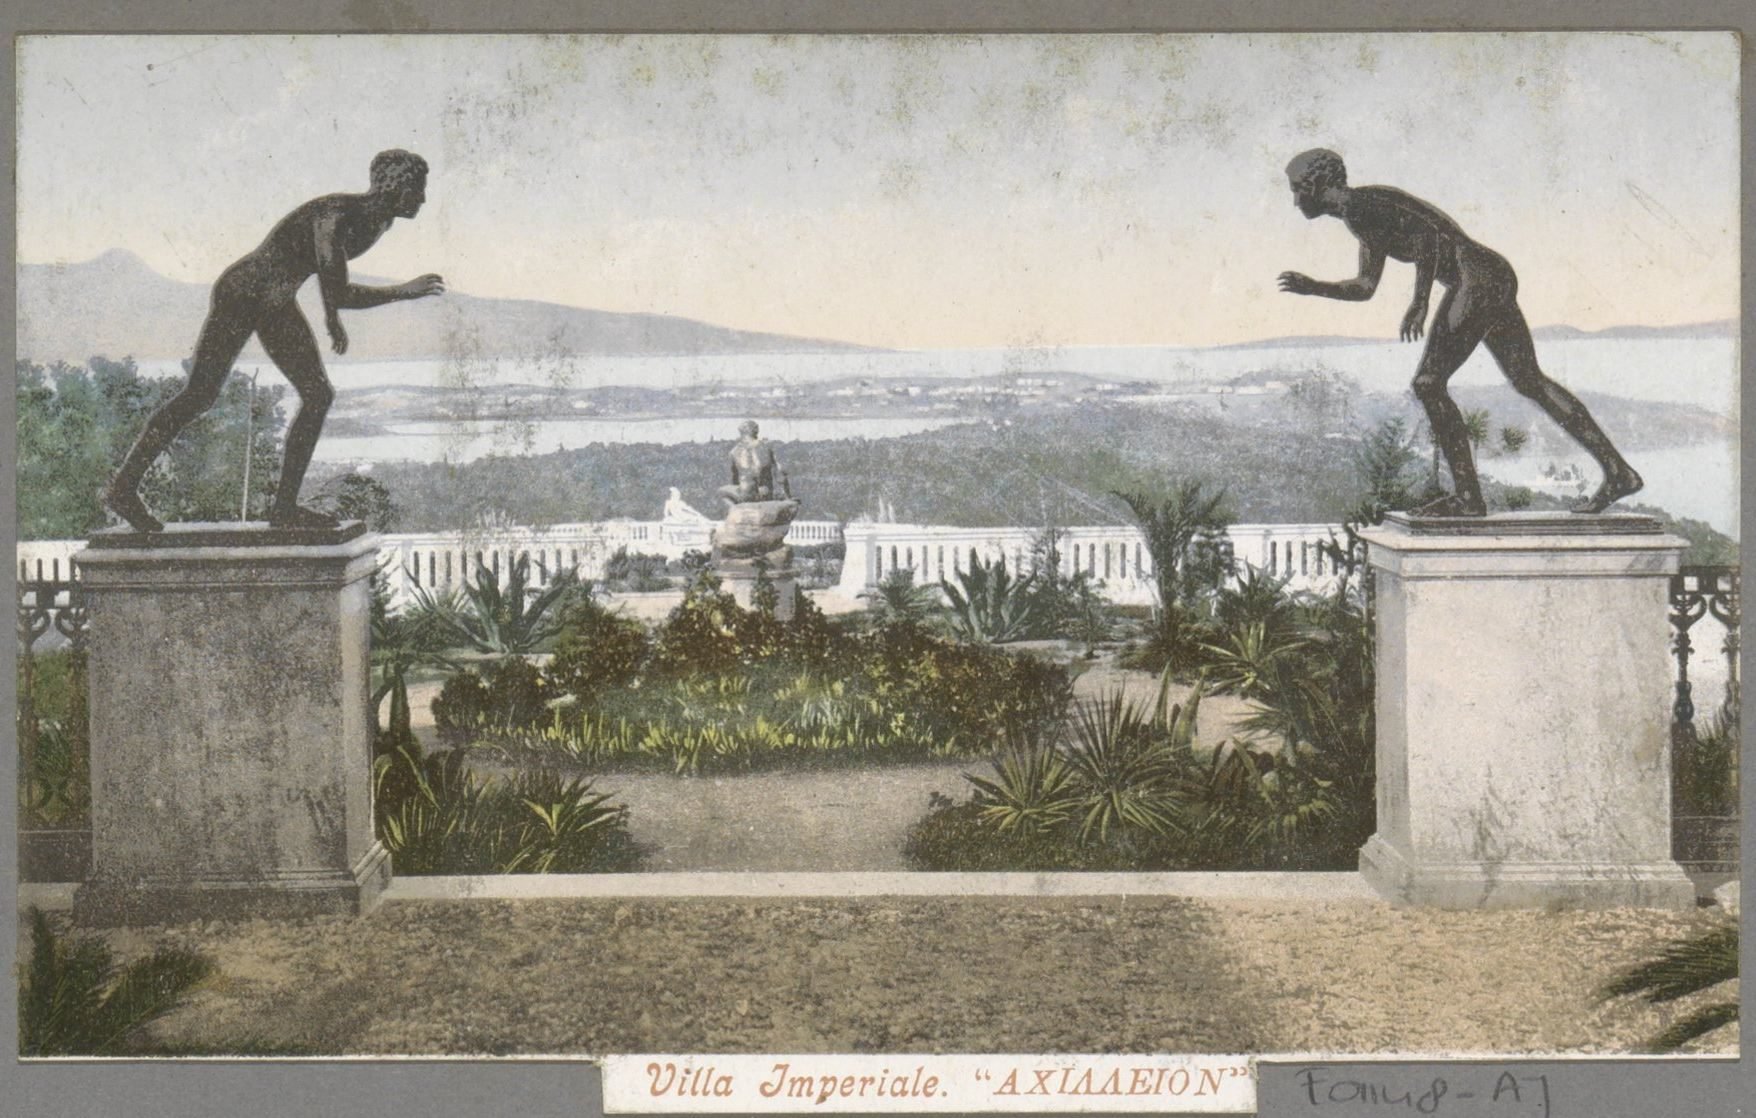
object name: album leaf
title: Villa Imperiale. Achilleion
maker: Anonymous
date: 1895-1905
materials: paper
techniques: lithograph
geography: corfu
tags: piece of sculpture, reproduction of a piece of sculpture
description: Onderdeel van Reisalbum met foto's van bezienswaardigheden in Griekenland en Egypte.